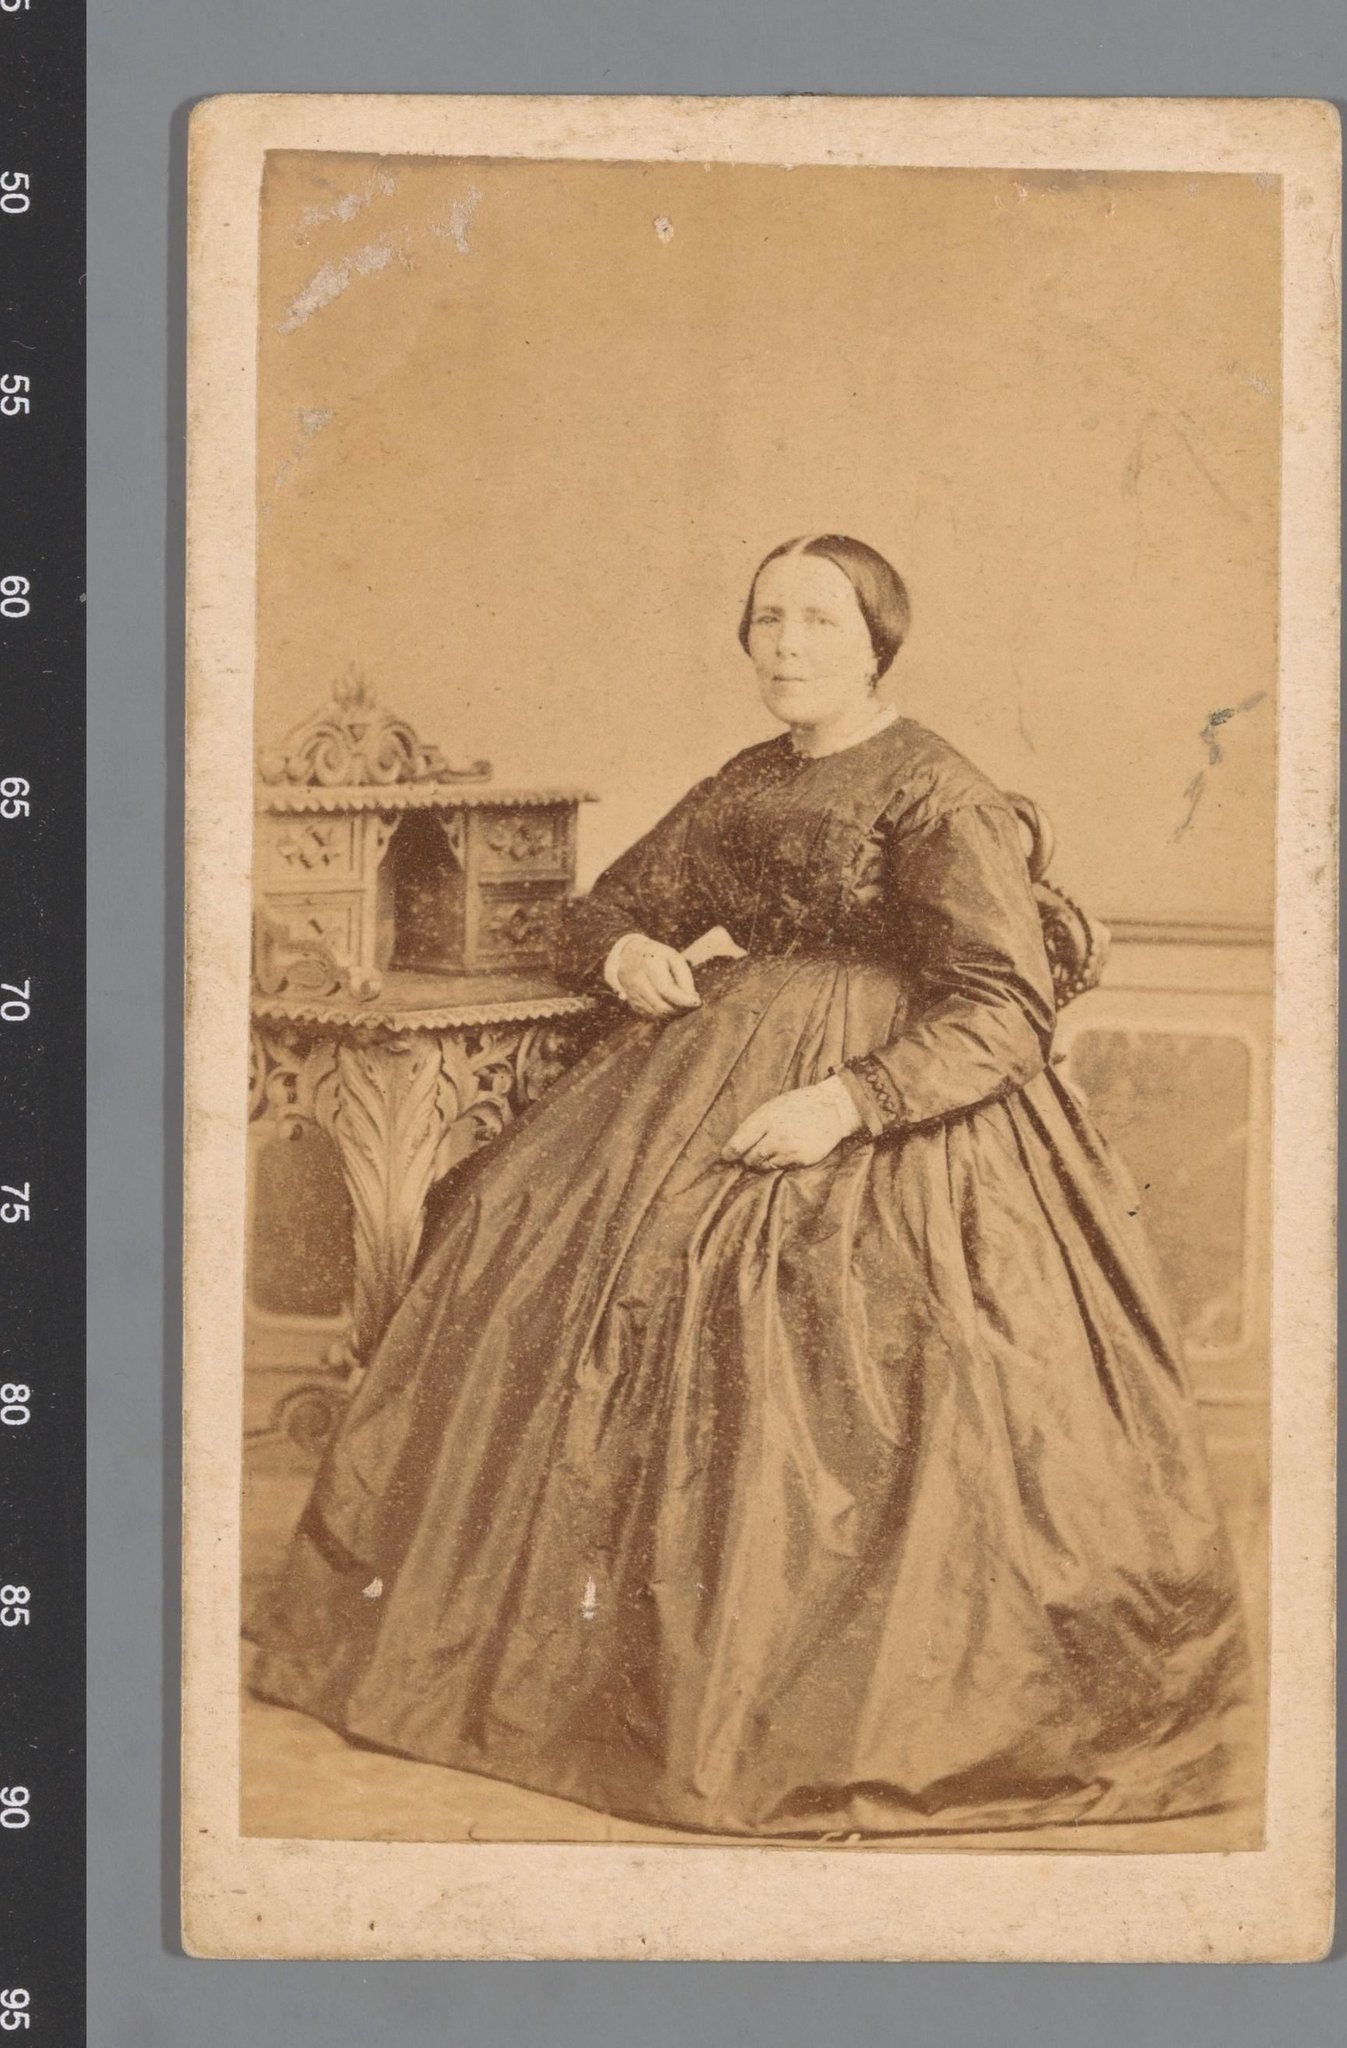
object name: carte de visite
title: Portret van een onbekende vrouw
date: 1863-1899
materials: cardboard, photographic support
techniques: albumen print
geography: netherlands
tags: historical persons not known by name - bb - woman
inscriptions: annotation: ‘wol jaren = 1860’, inscription: ‘K / E. Kirchner & Comp. / Zuiderstraat / bij de Oostpoort / DELFT.’, number: ‘85’